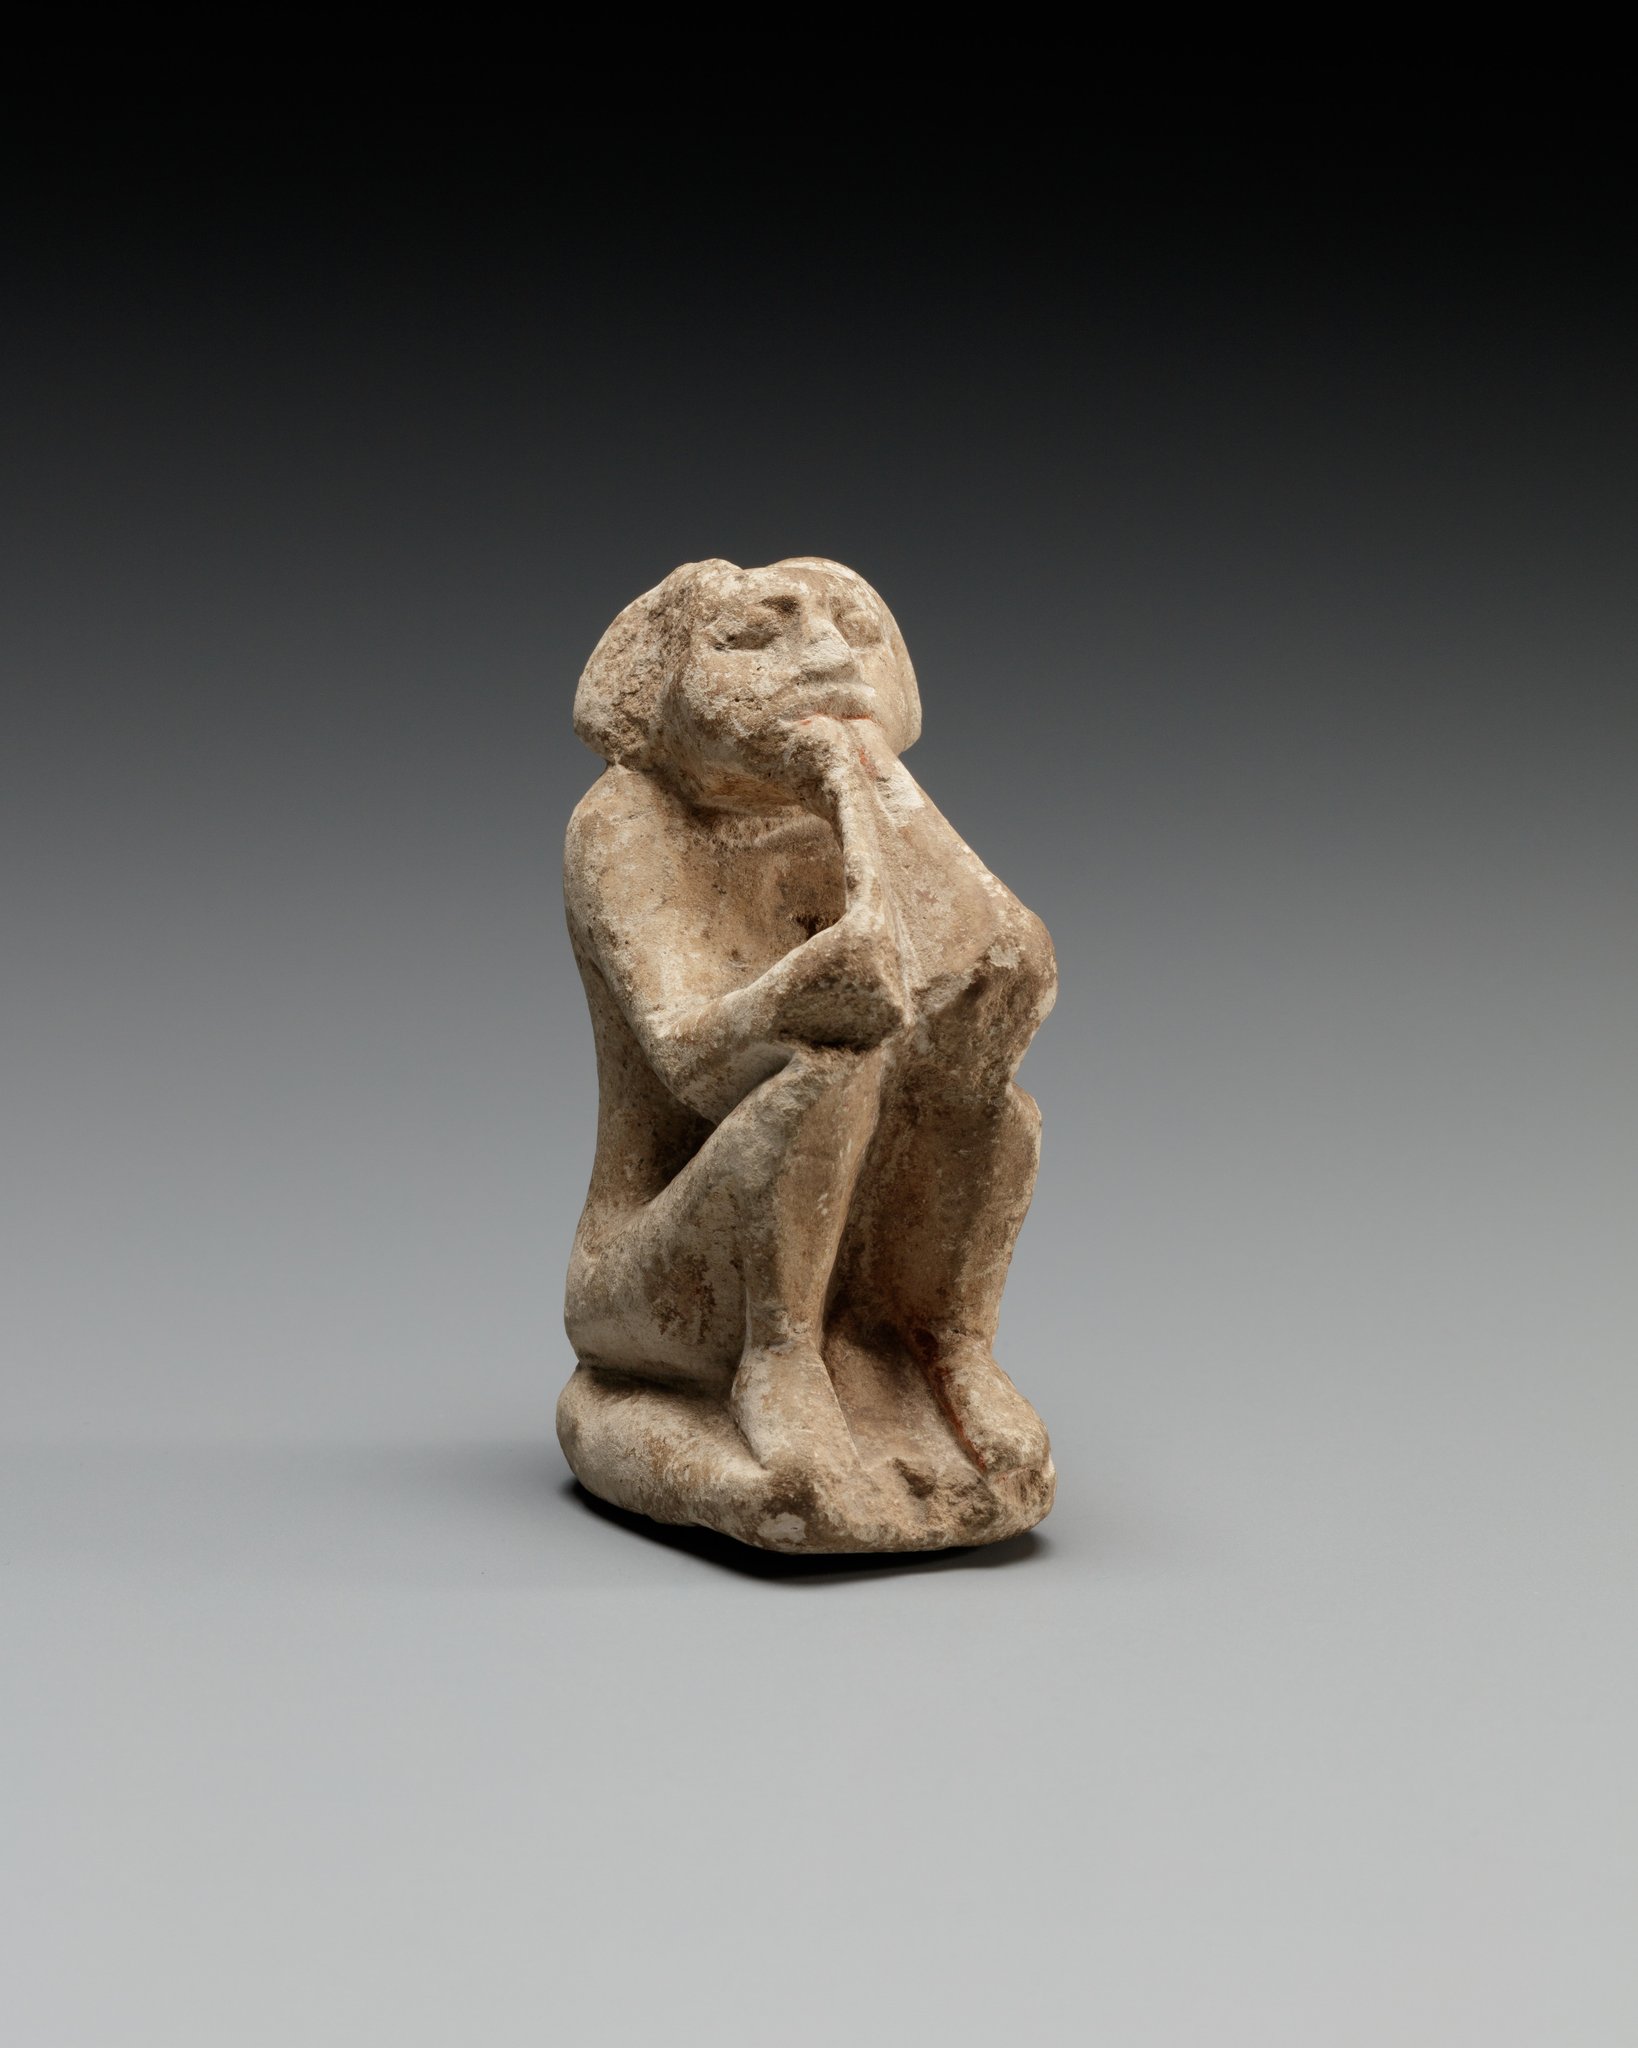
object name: statuette of a flute player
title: Flute player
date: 1550-1295 BCE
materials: limestone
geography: egypt